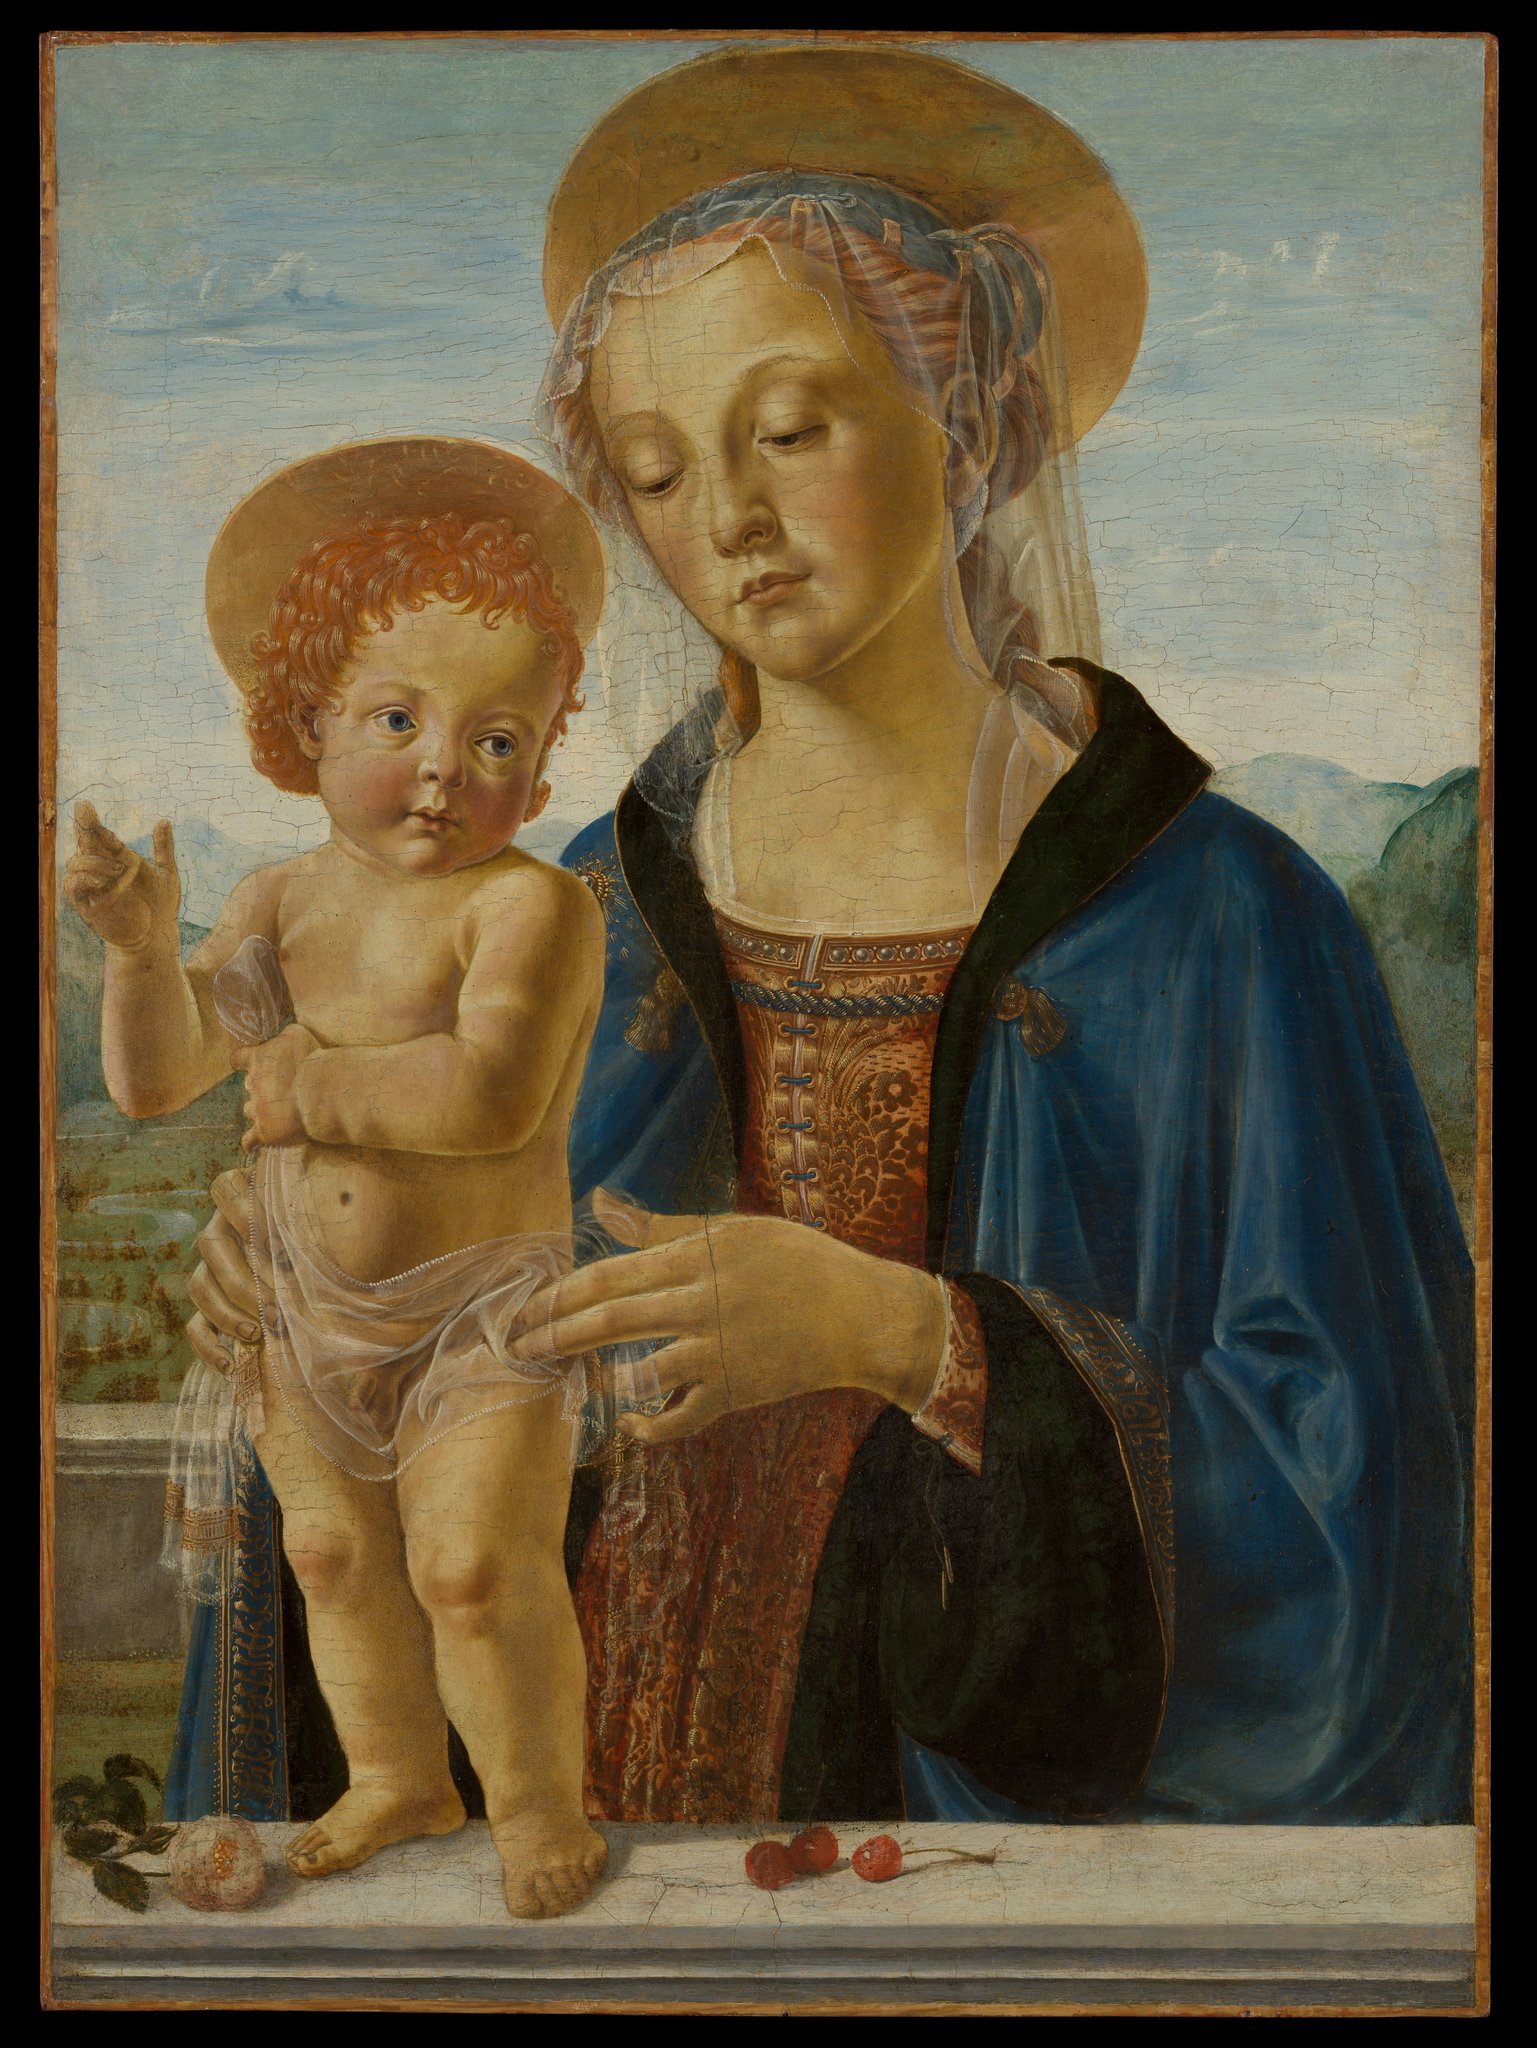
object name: painting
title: Madonna and Child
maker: andrea del verrocchio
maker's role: artist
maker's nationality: italian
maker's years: 1435-1488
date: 1470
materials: gold, paint, wood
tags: cherries,madonna and child